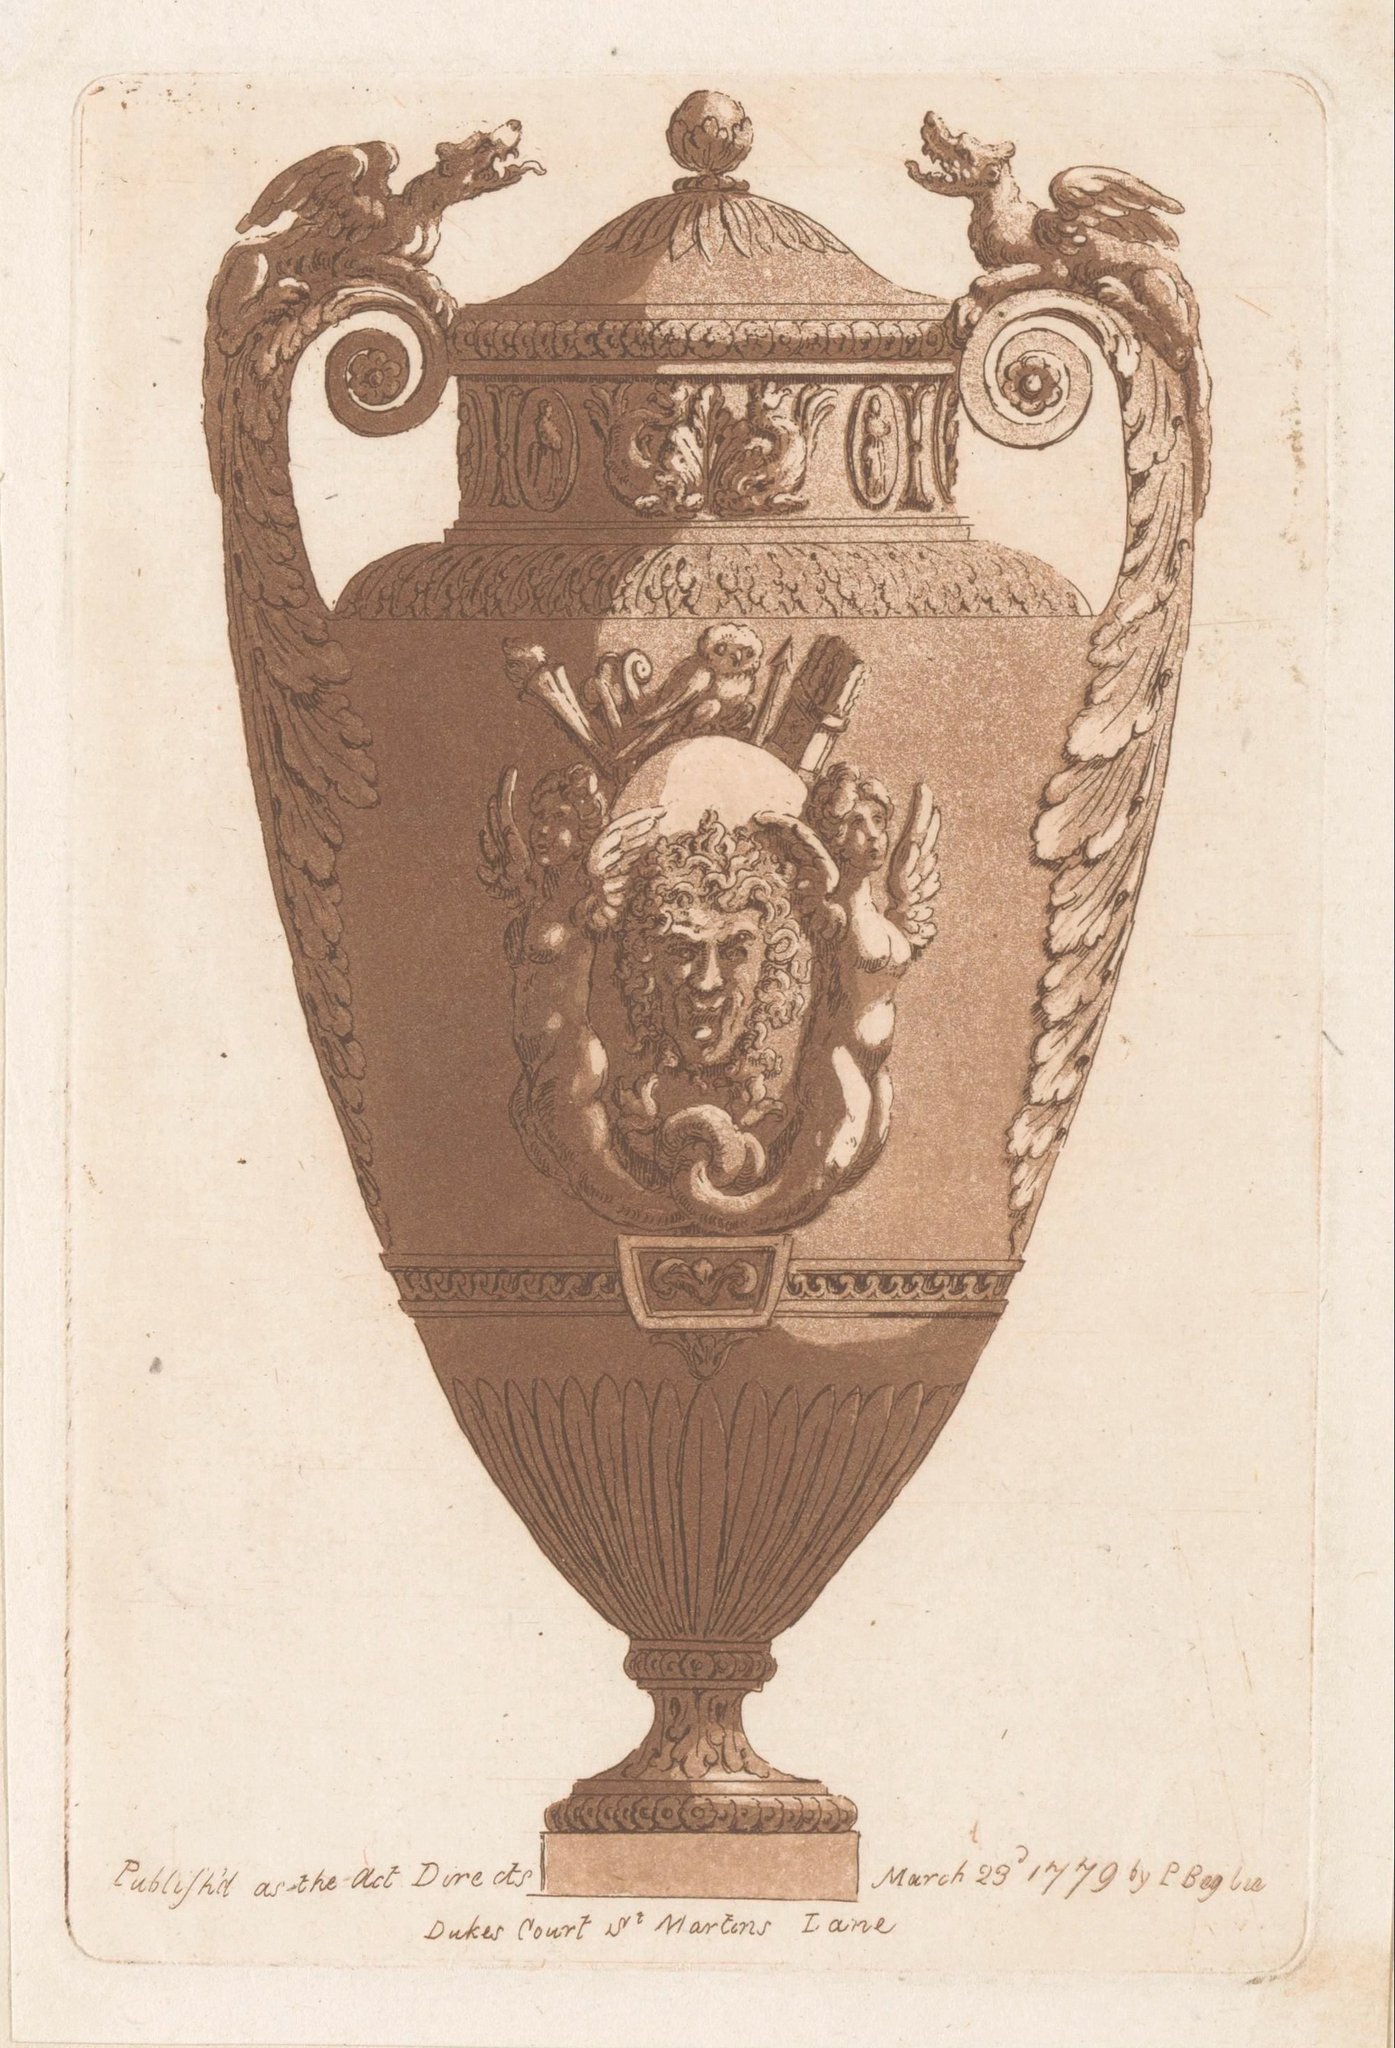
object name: print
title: Antieke vaas met medaillon met lachende kop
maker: patrick begbie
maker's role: print maker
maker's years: -1820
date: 1779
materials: paper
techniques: aquatint, etching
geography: london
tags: ornament ~ medallion, vase ~ ornament, owls, dragon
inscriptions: collector's mark: Lugt 2228, collector's mark: Lugt 2760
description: Een antieke geornamenteerde vaas met medaillon met lachende kop met vrouwelijke figuren aan weerszijden en bekroond door een uil. Met twee oren met draakachtige figuren.